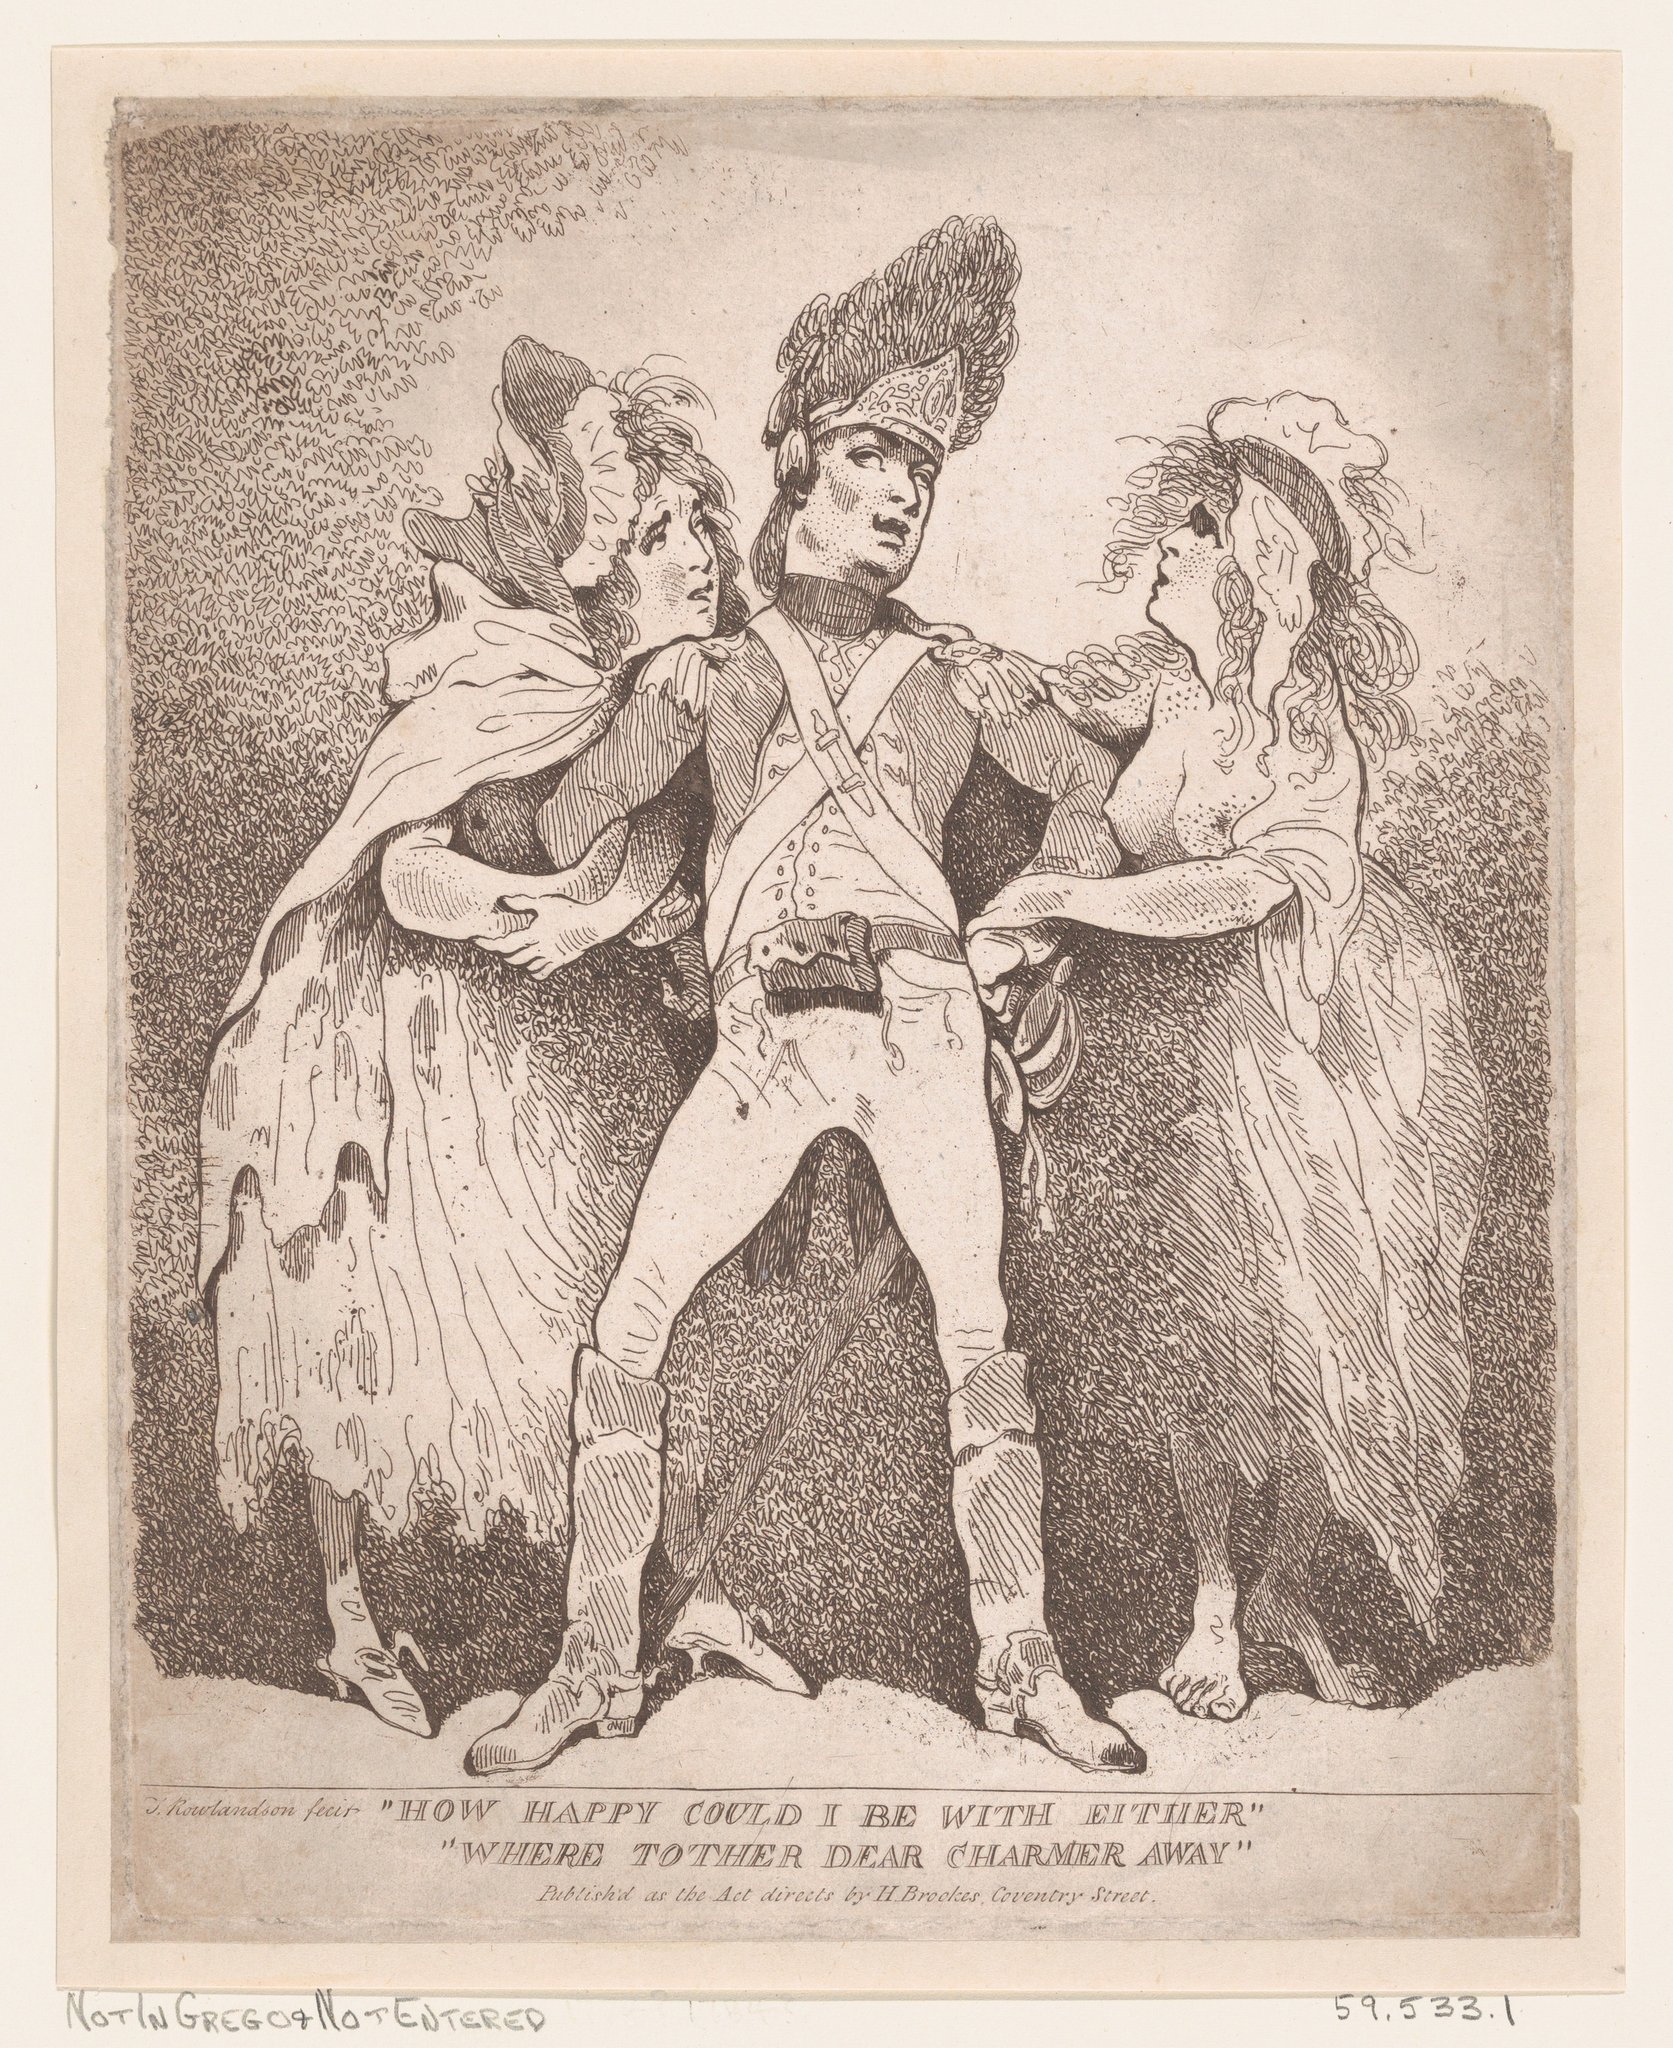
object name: print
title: How Happy Could I Be With Either, Were t'Other Dear Charmer Away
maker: thomas rowlandson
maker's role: artist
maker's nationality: british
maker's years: 1757-1827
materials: ink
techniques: etching, printing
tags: satire,soldiers,men,women,female nudes